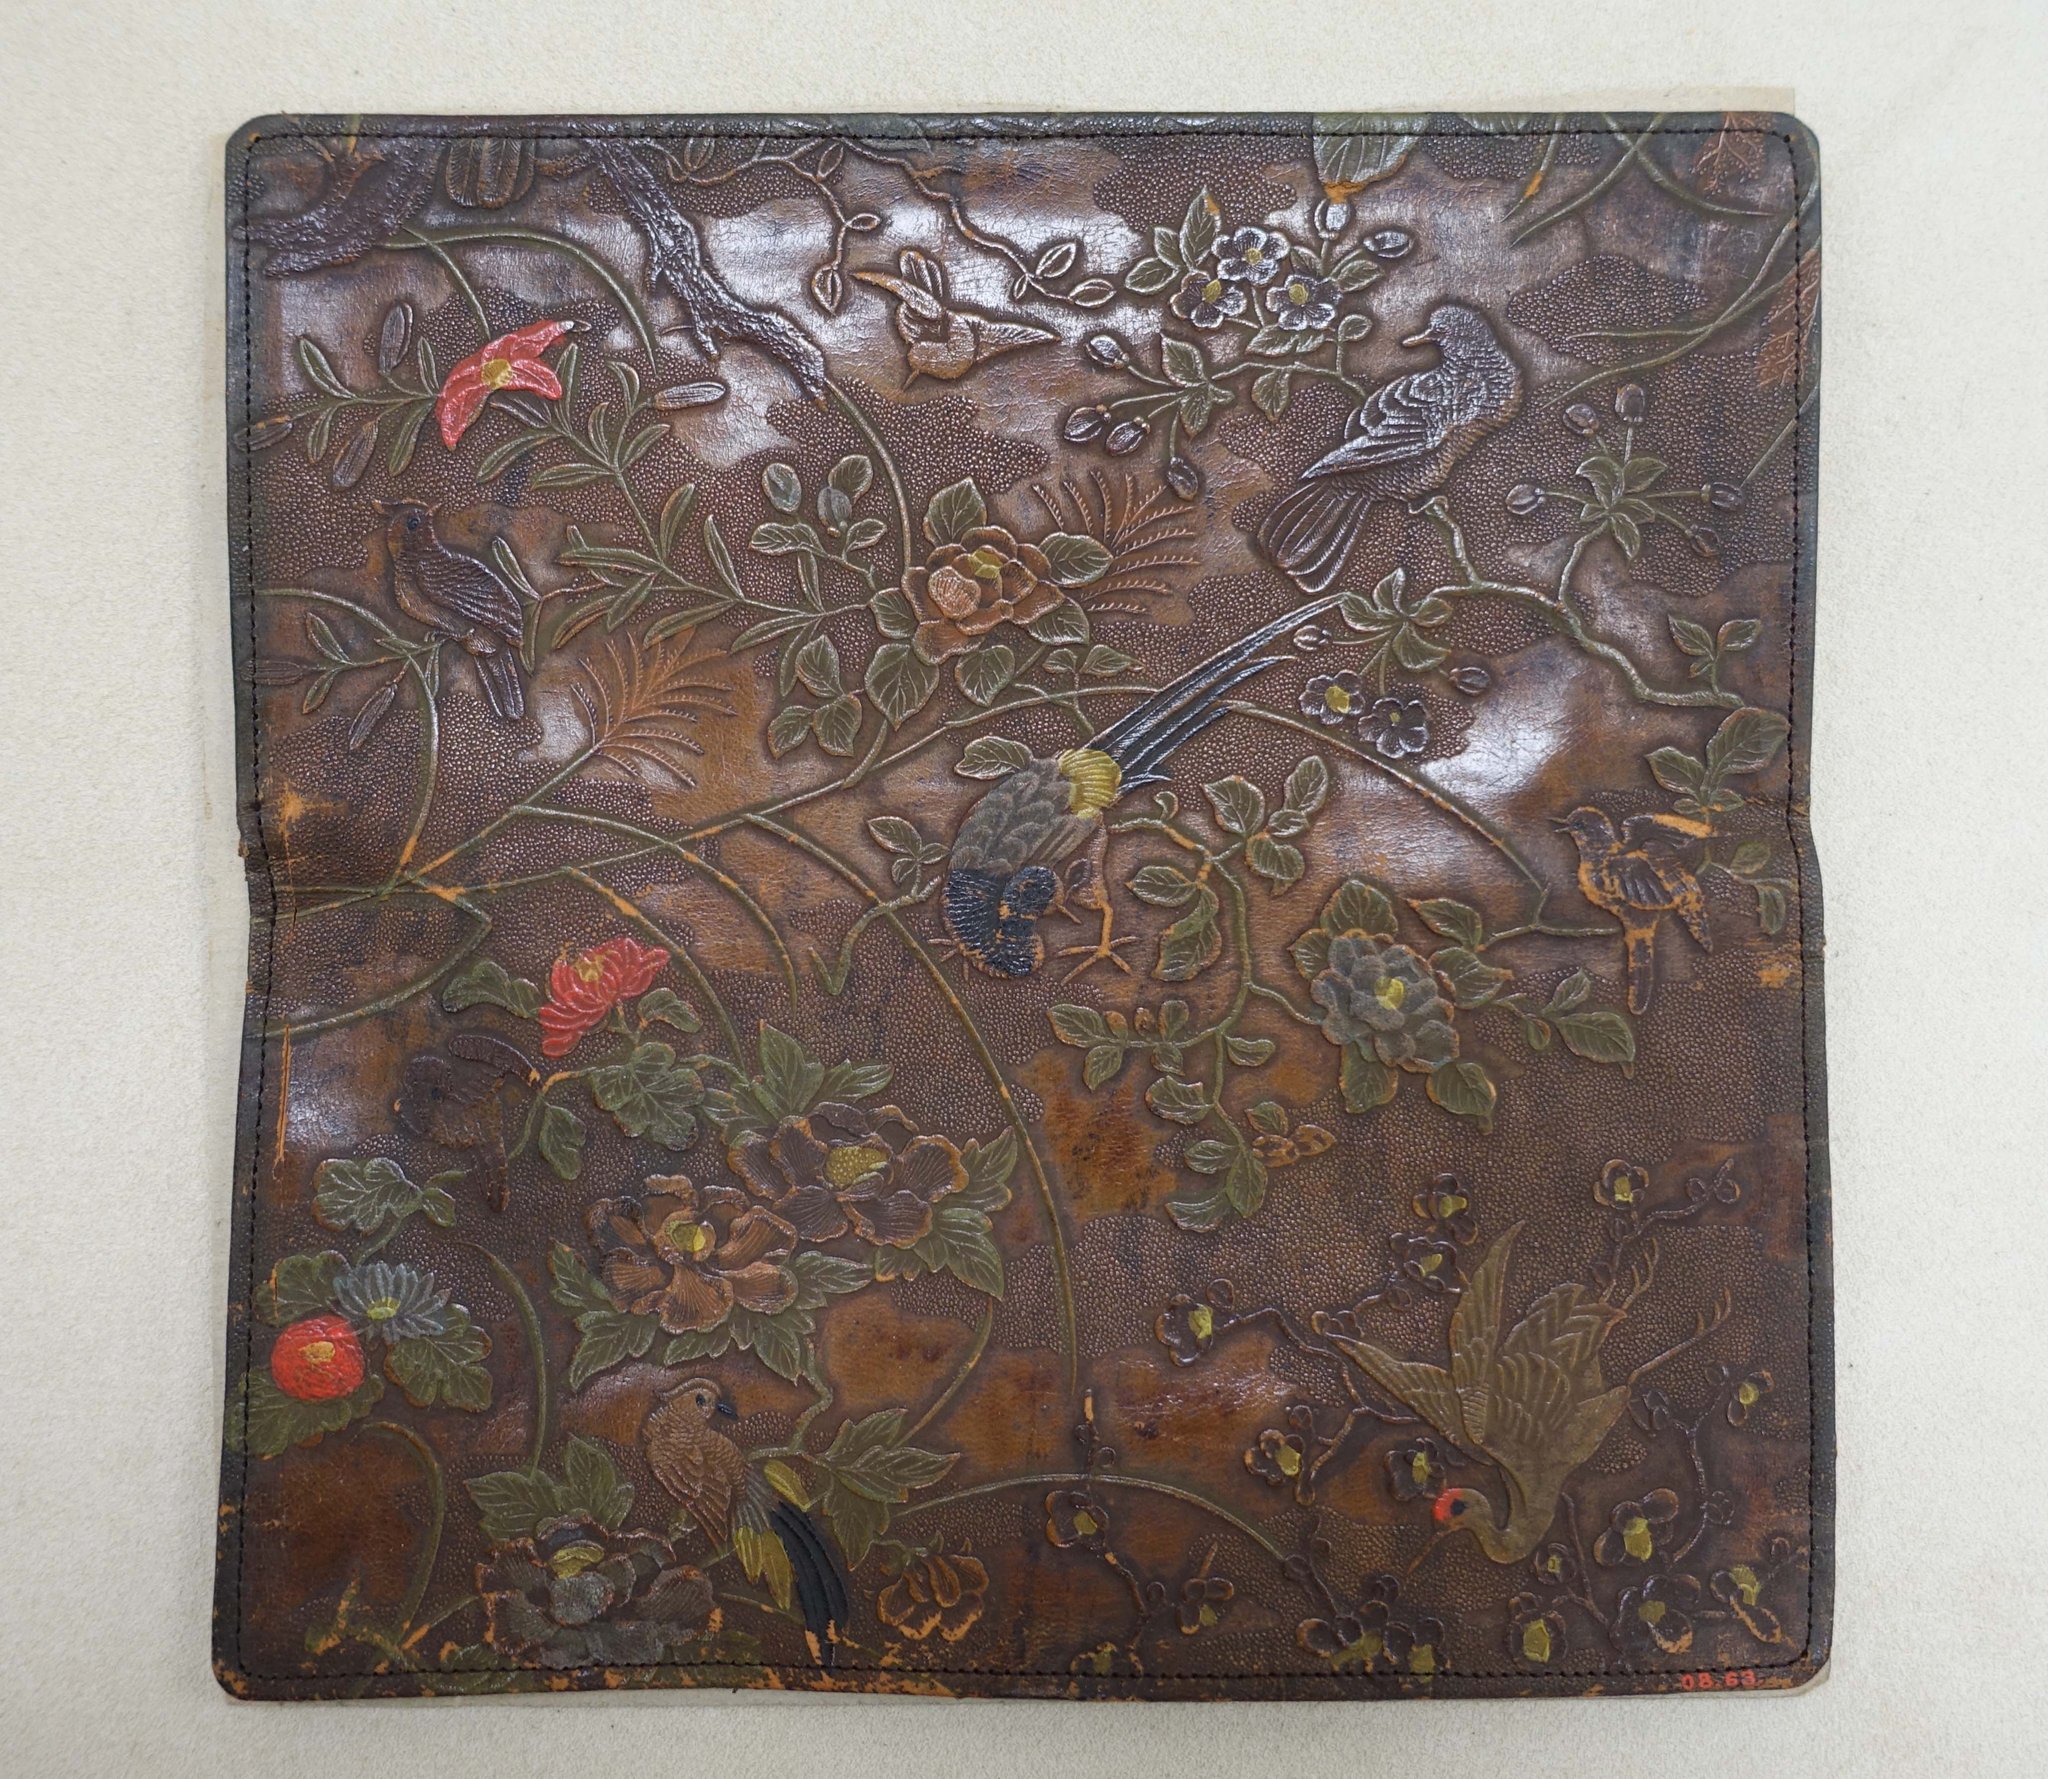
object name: panel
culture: japanese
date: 1801-1900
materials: leather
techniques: stamping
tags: flowers,leaves